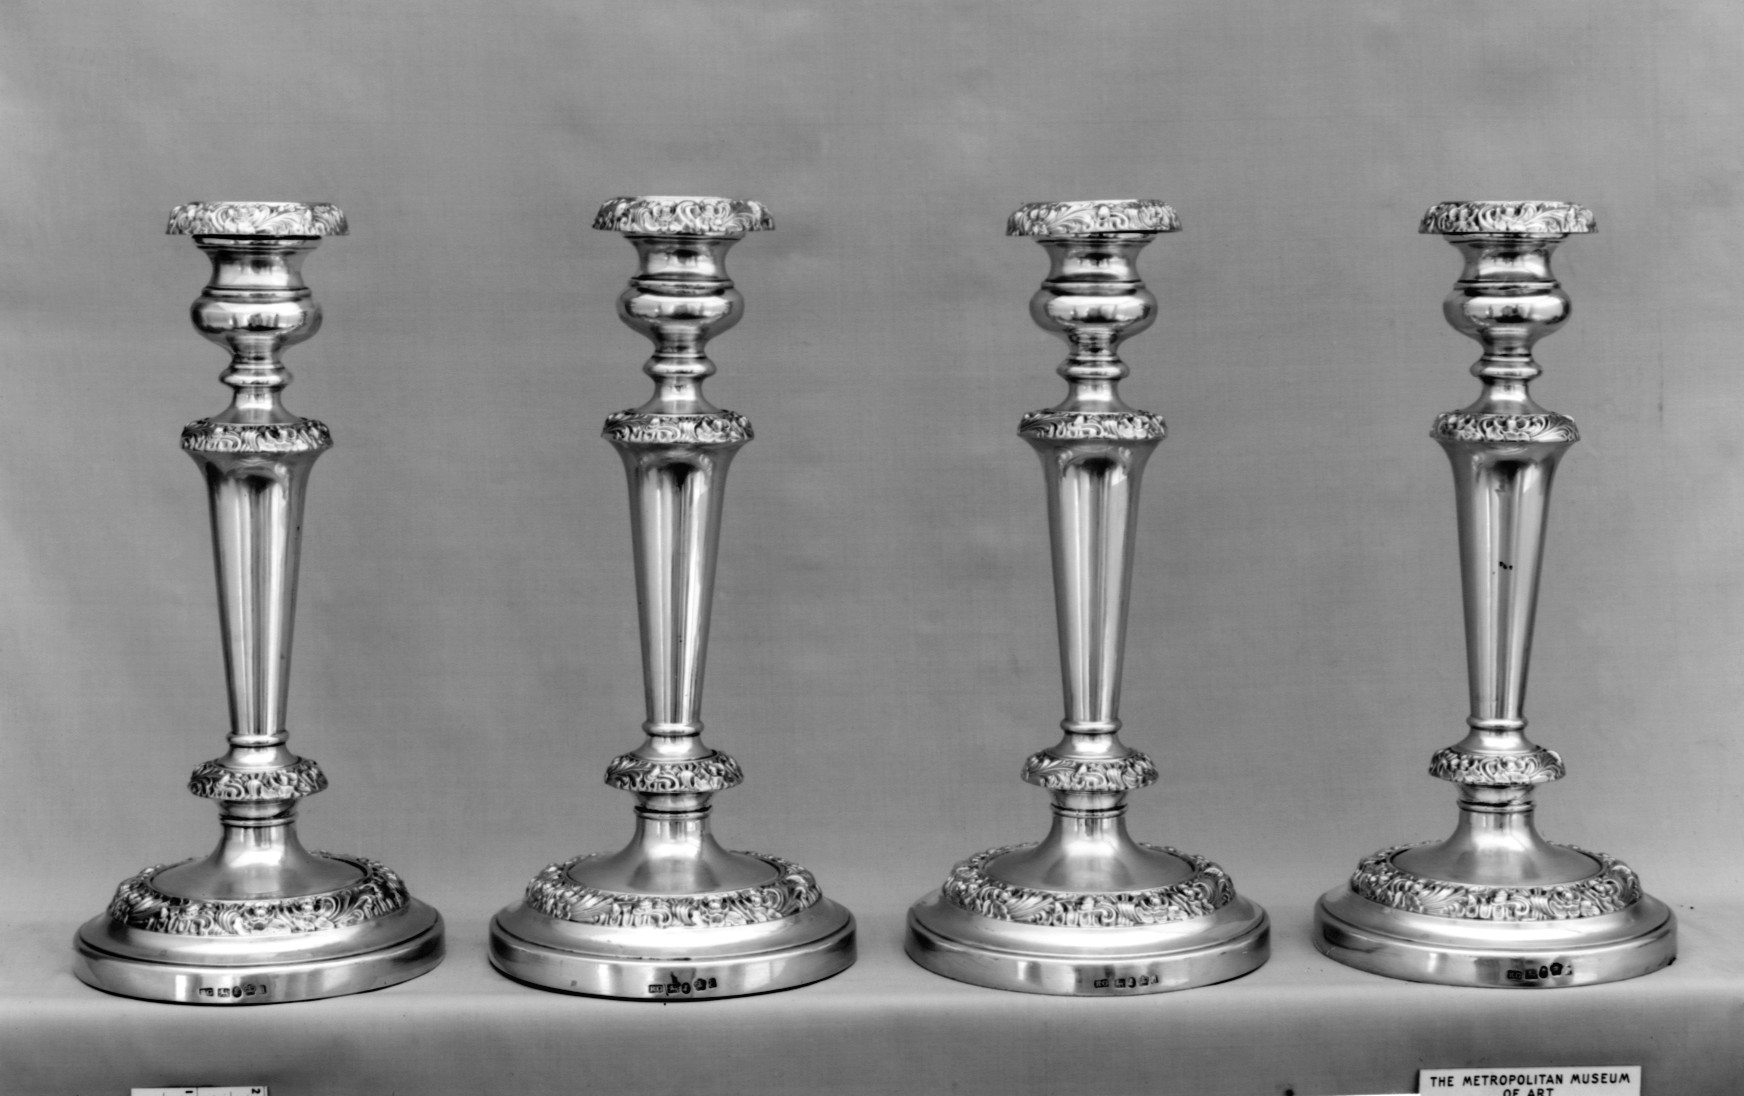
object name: candlestick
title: Four candlesticks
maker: r. gainsforth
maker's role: maker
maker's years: 1725-1825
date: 1824-1825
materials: silver